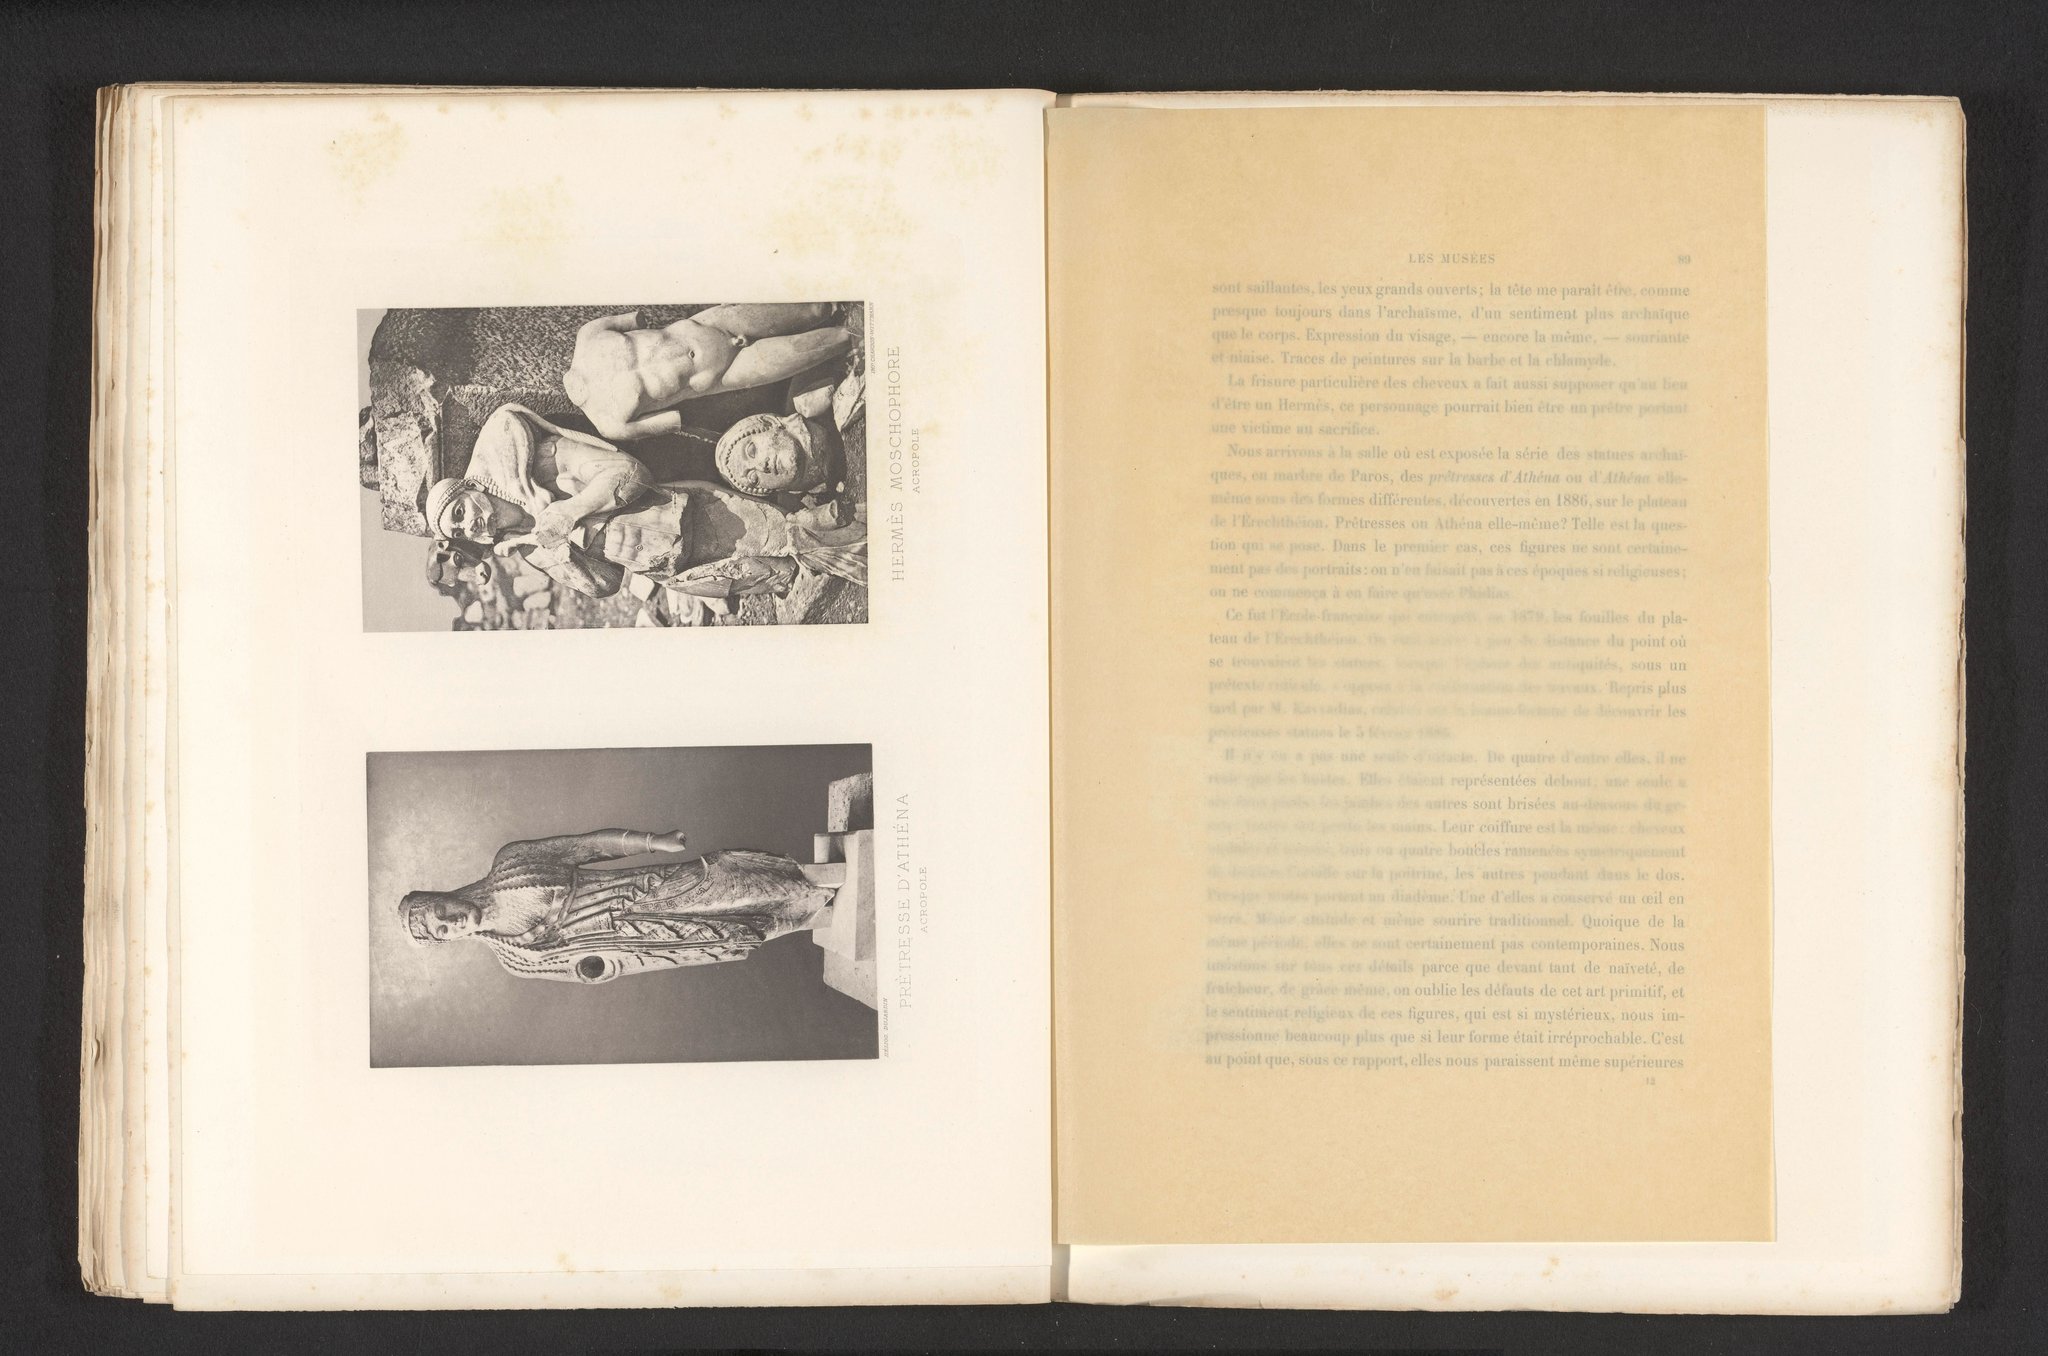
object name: photomechanical print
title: Sculptuur van een priesteres van Pallas Athena en een sculptuur van Hermes met een kalf op de schouders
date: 1880-1890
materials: paper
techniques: photoaquatint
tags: (story of) mercury (hermes), priest ~ greek religion - ee - priestess, calf, sculpture